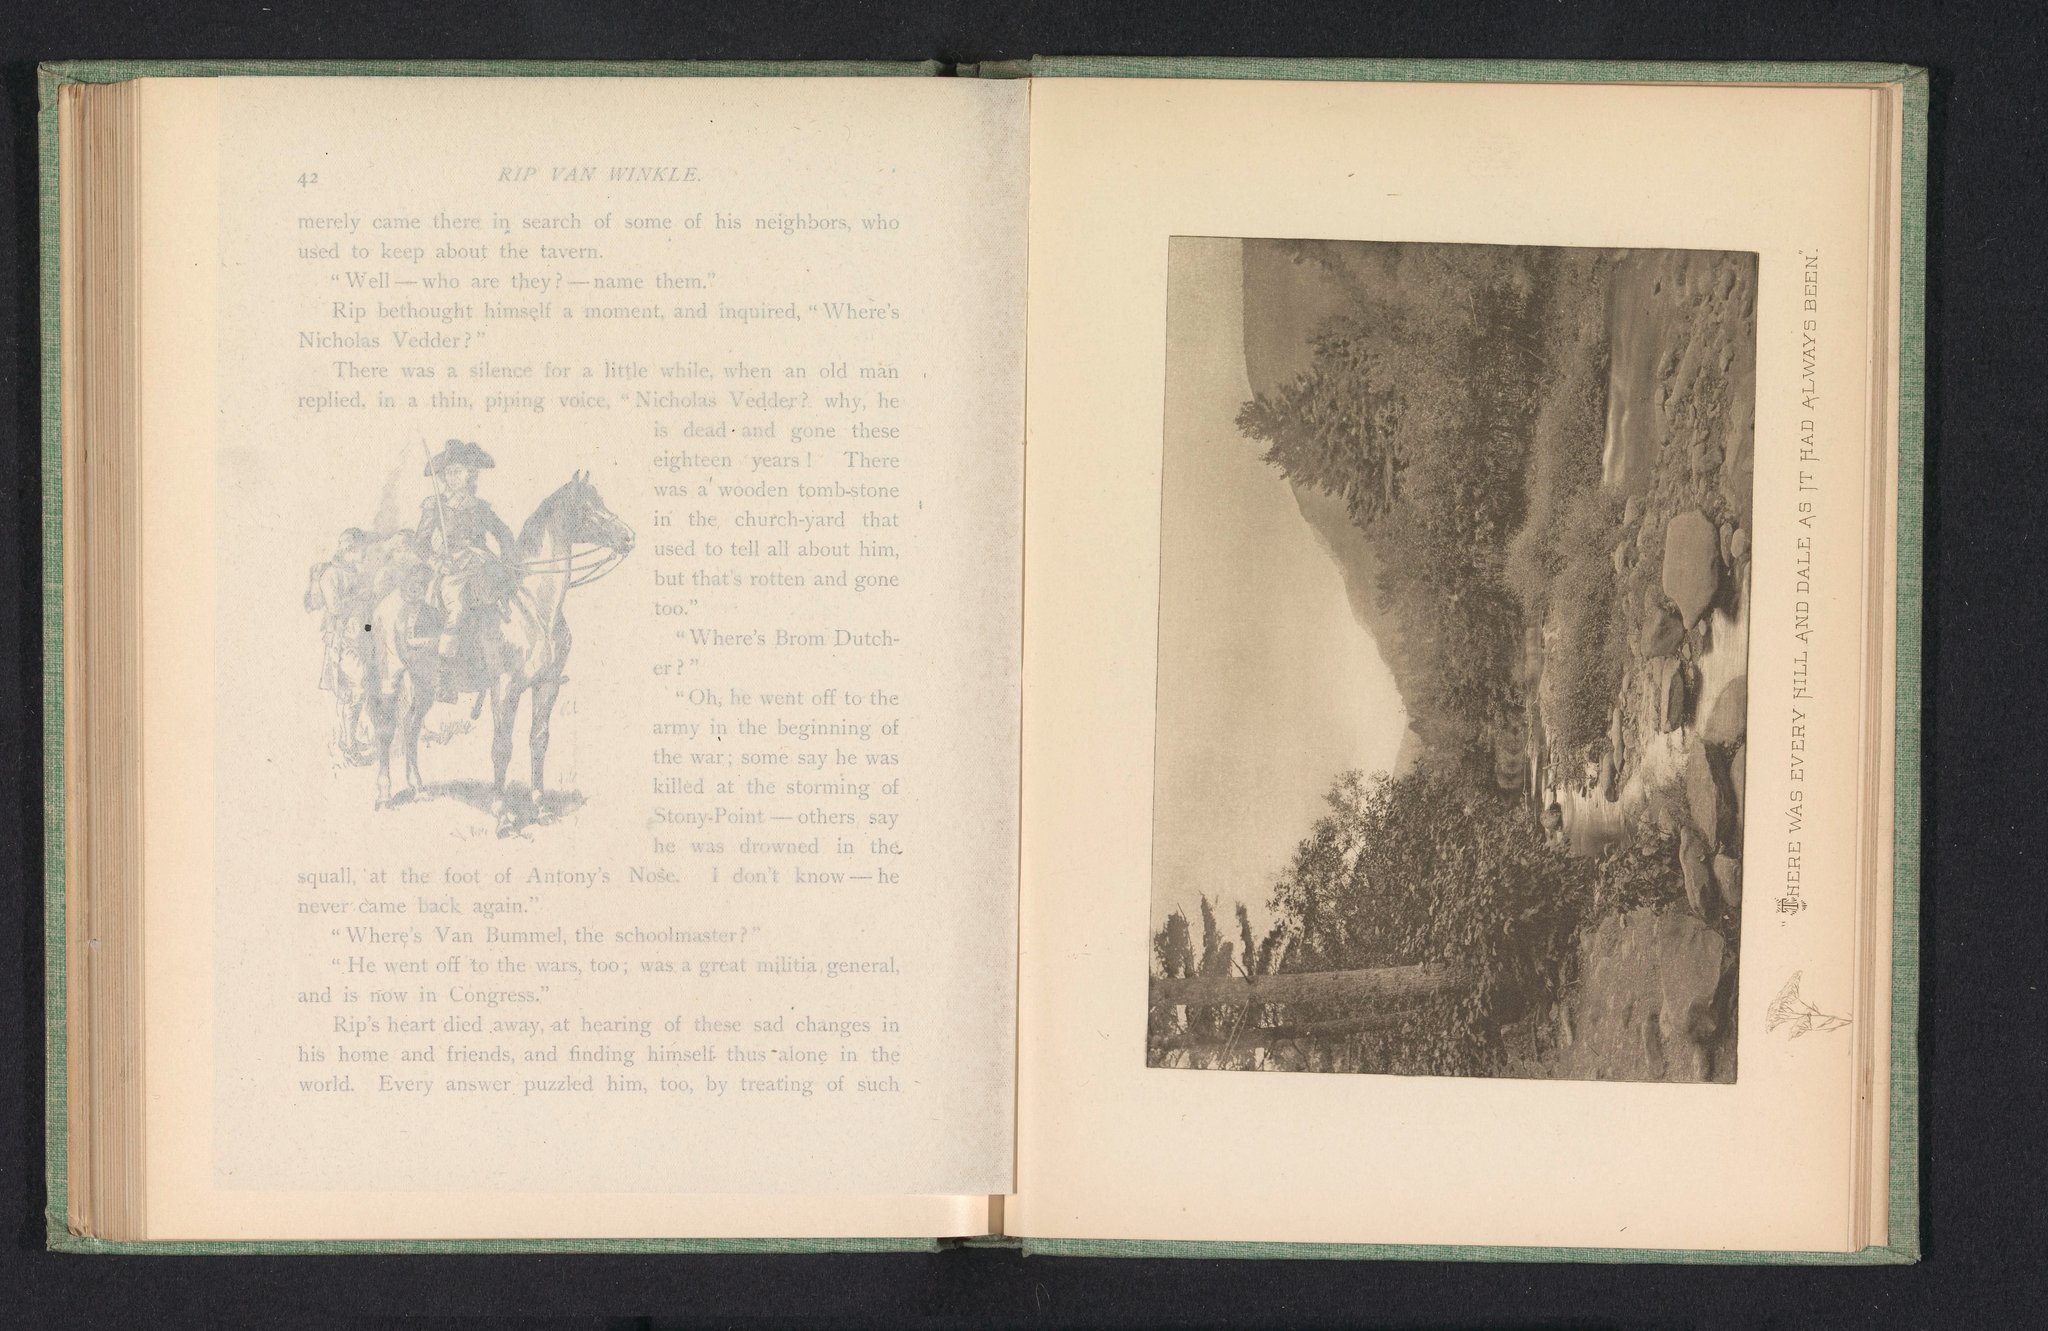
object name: page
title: Gezicht op een rivier, bossen en bergen in het Catskillgebergte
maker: Anonymous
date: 1884-1894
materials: paper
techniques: photoaquatint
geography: catskill mountains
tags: river, forest, wood, mountains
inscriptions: inscription: ‘“There was every hill and dale as it had always been.”’